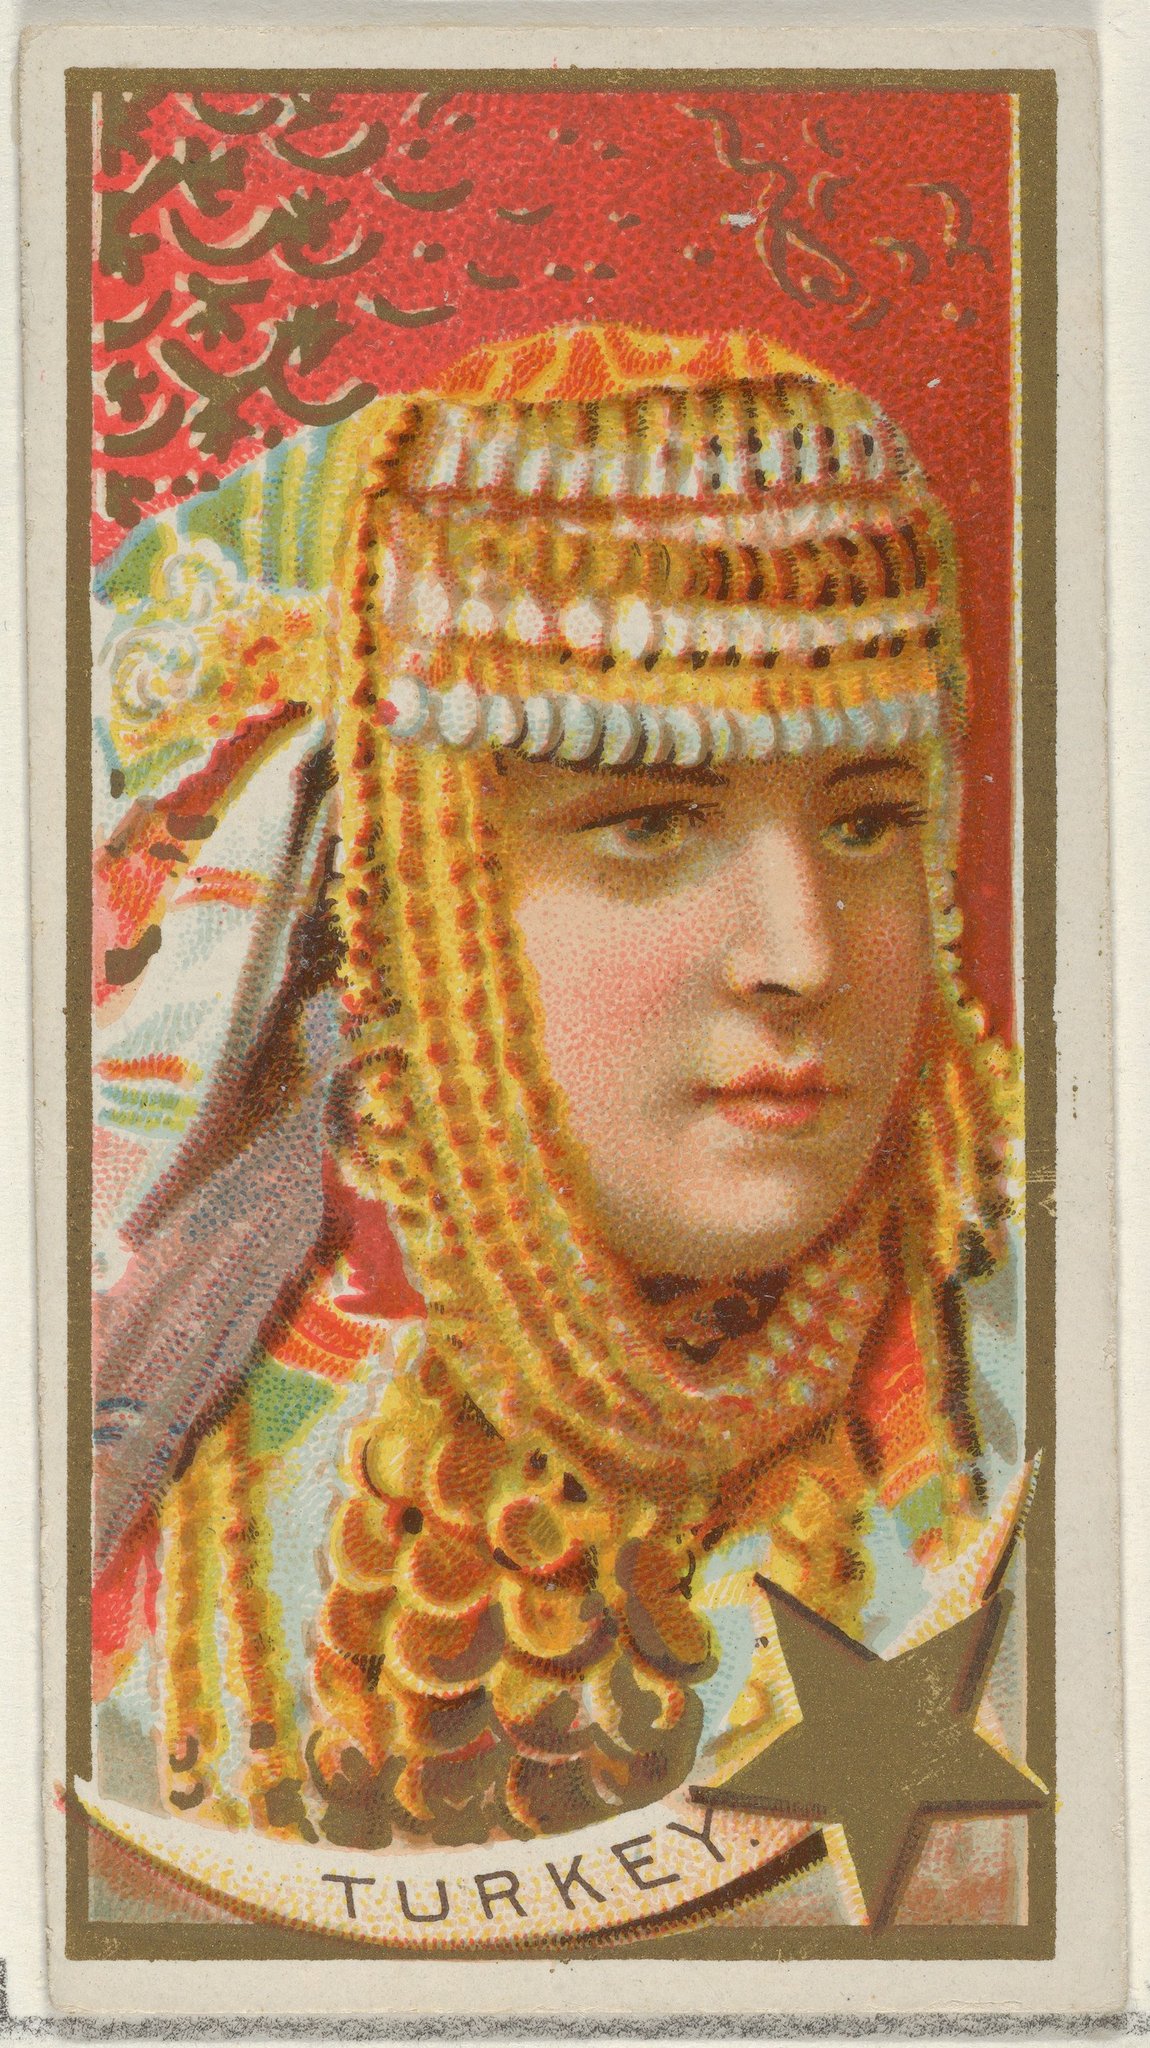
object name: print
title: Turkey, from the Types of All Nations series (N24) for Allen & Ginter Cigarettes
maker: allen & ginter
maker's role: publisher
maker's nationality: american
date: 1889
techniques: color lithograph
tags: women